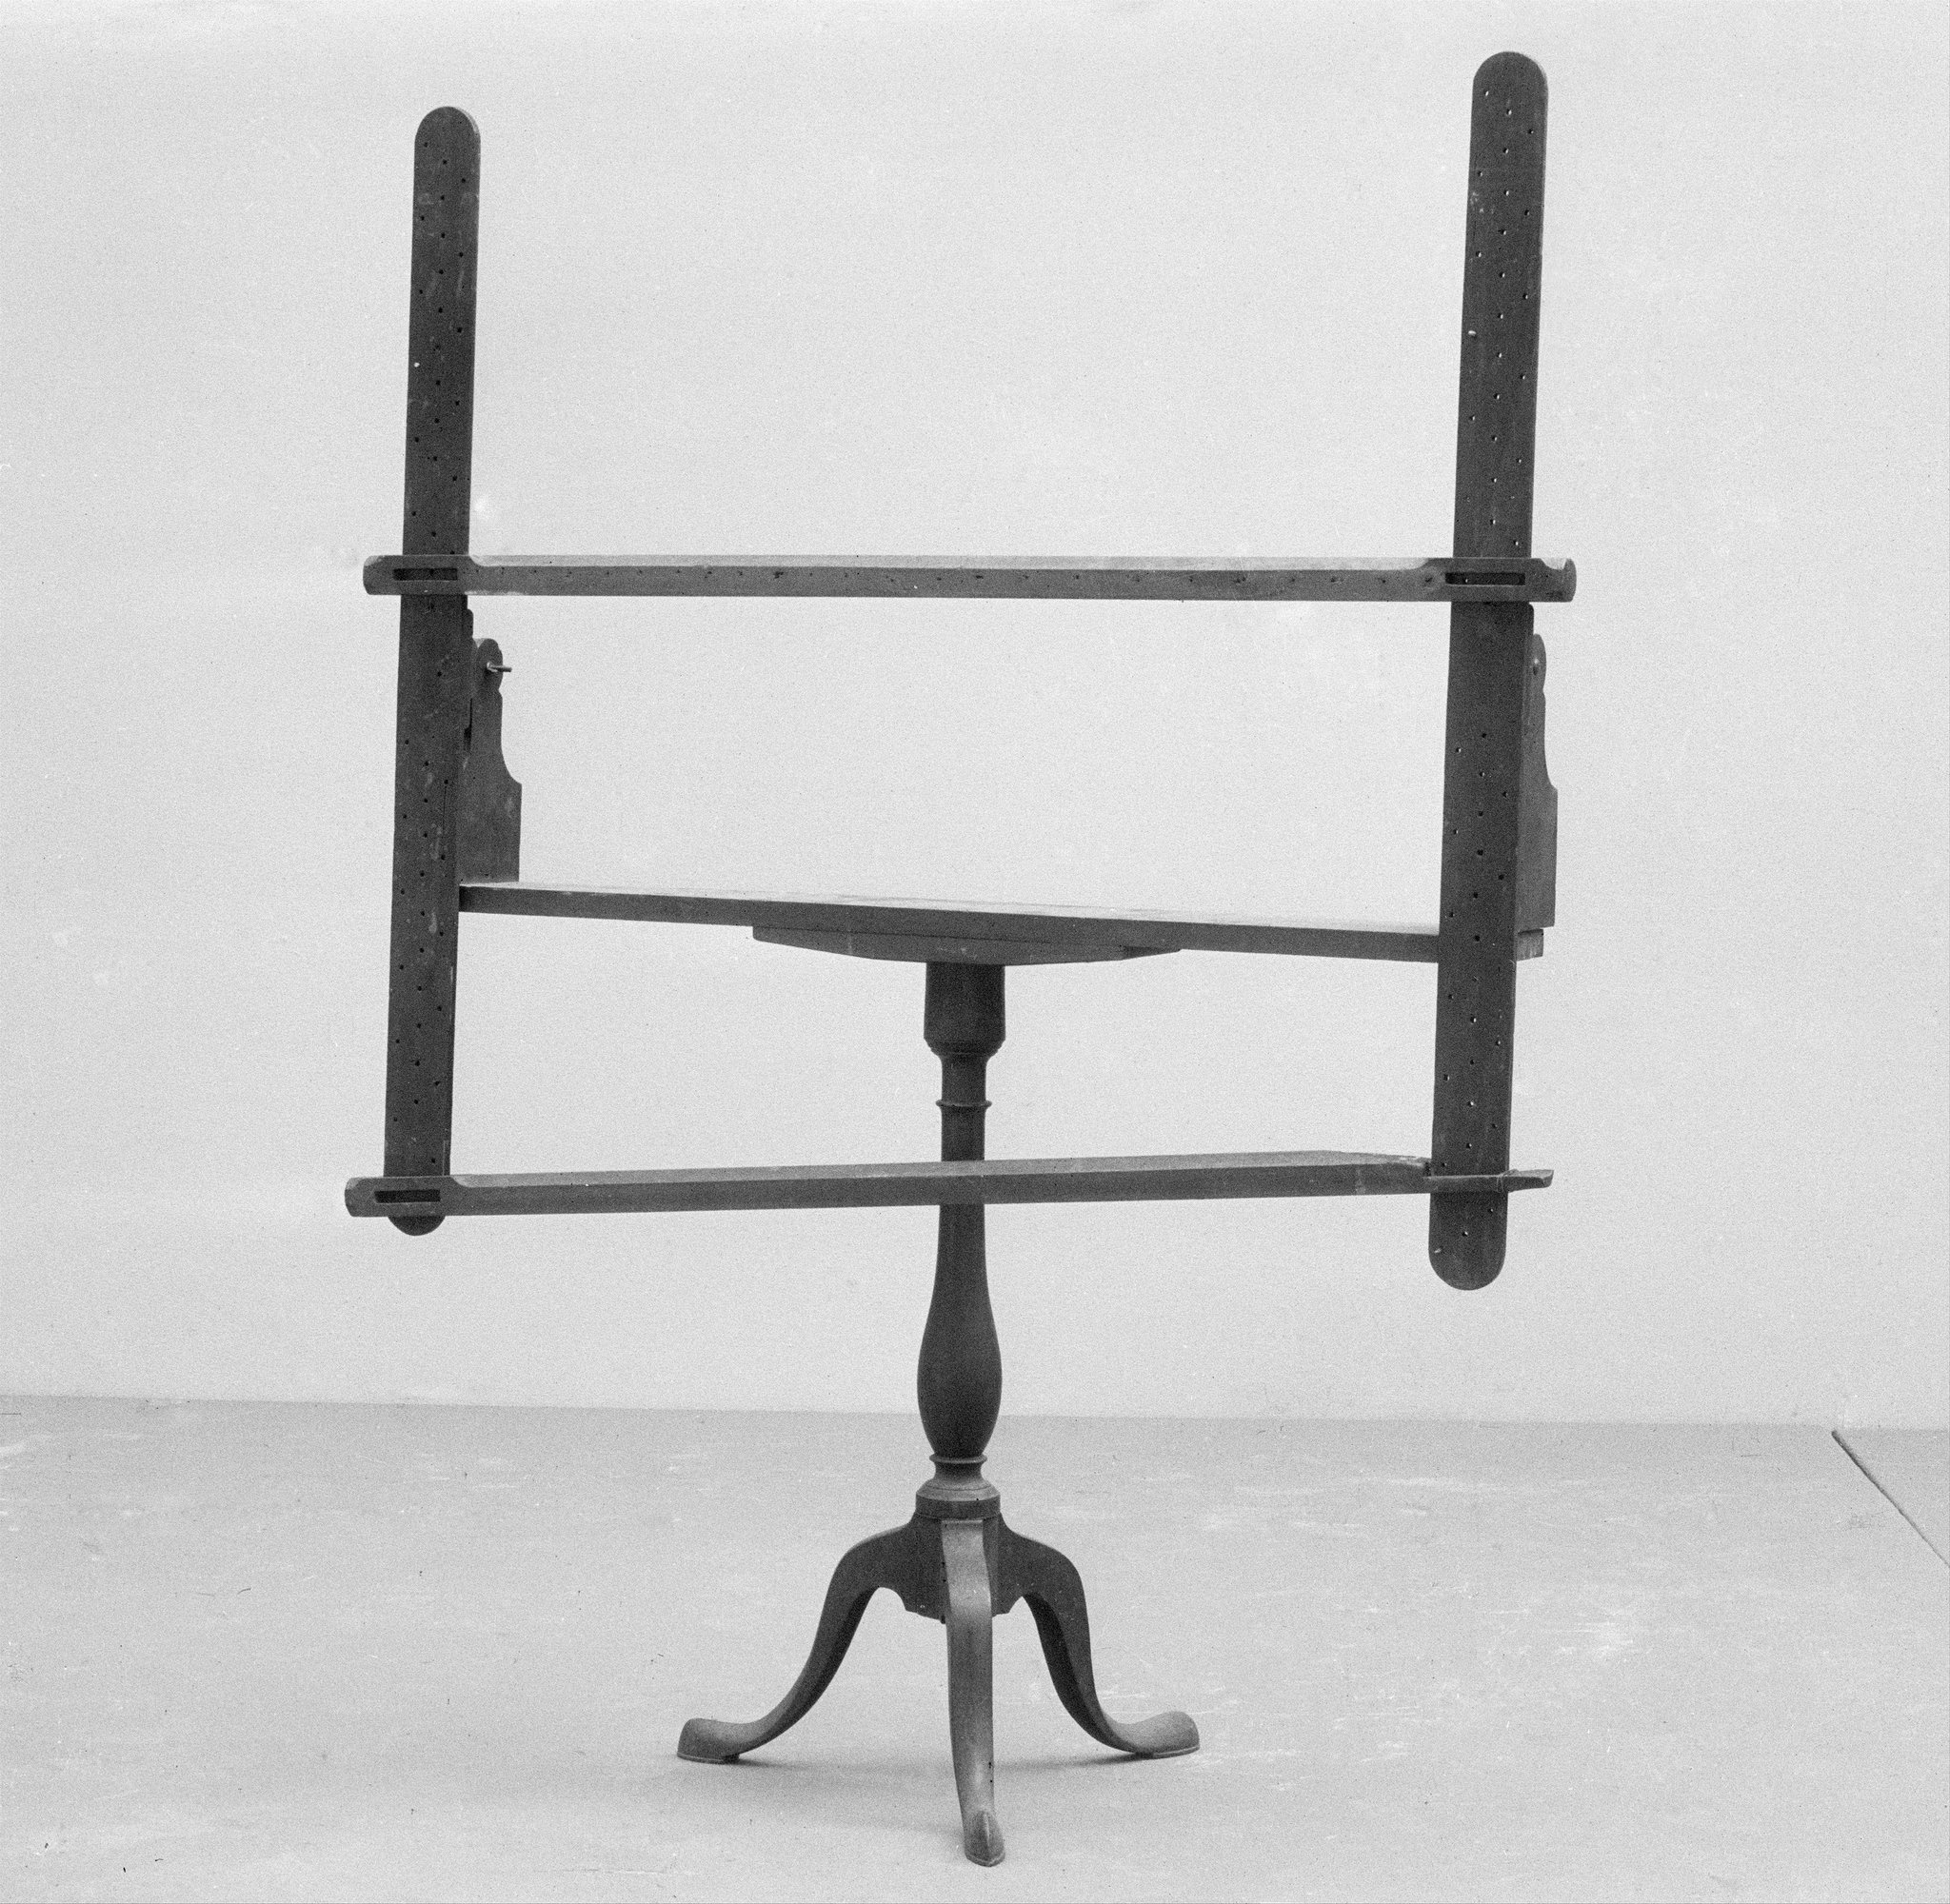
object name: embroidery frame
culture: american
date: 1725-1790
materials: wood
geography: united states